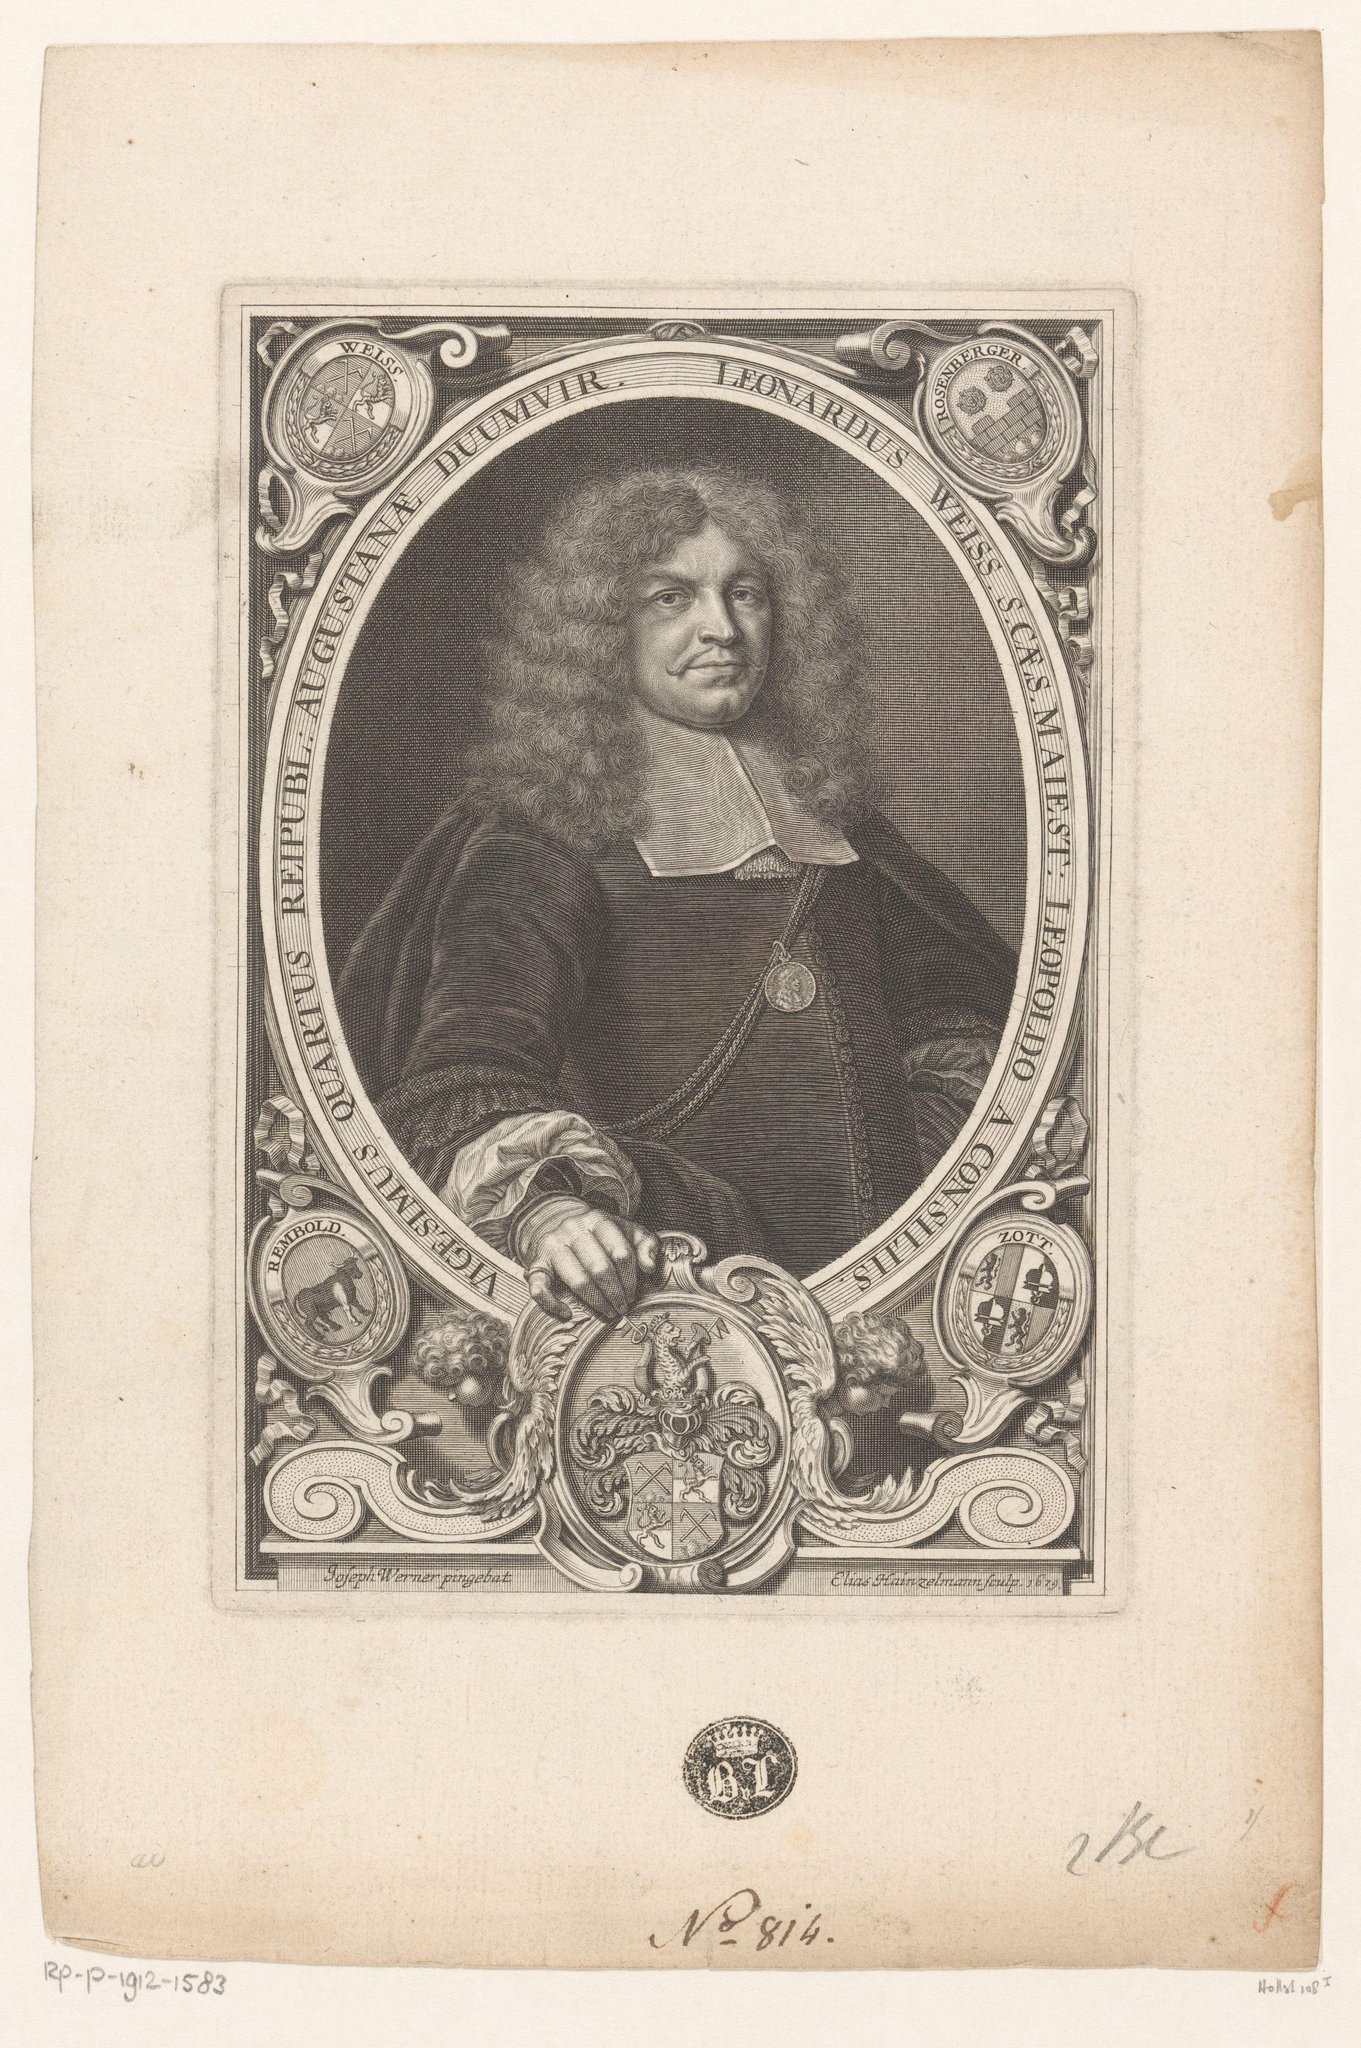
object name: print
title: Portret van Leonhard Weiß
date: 1679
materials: paper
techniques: engraving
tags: politician, mayor, cherubs, i.e. children's heads with wings, historical persons, pendant, trinket, 'breloque', armorial bearing, heraldry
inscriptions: collector's mark: Lugt 2228, collector's mark: Lugt 417